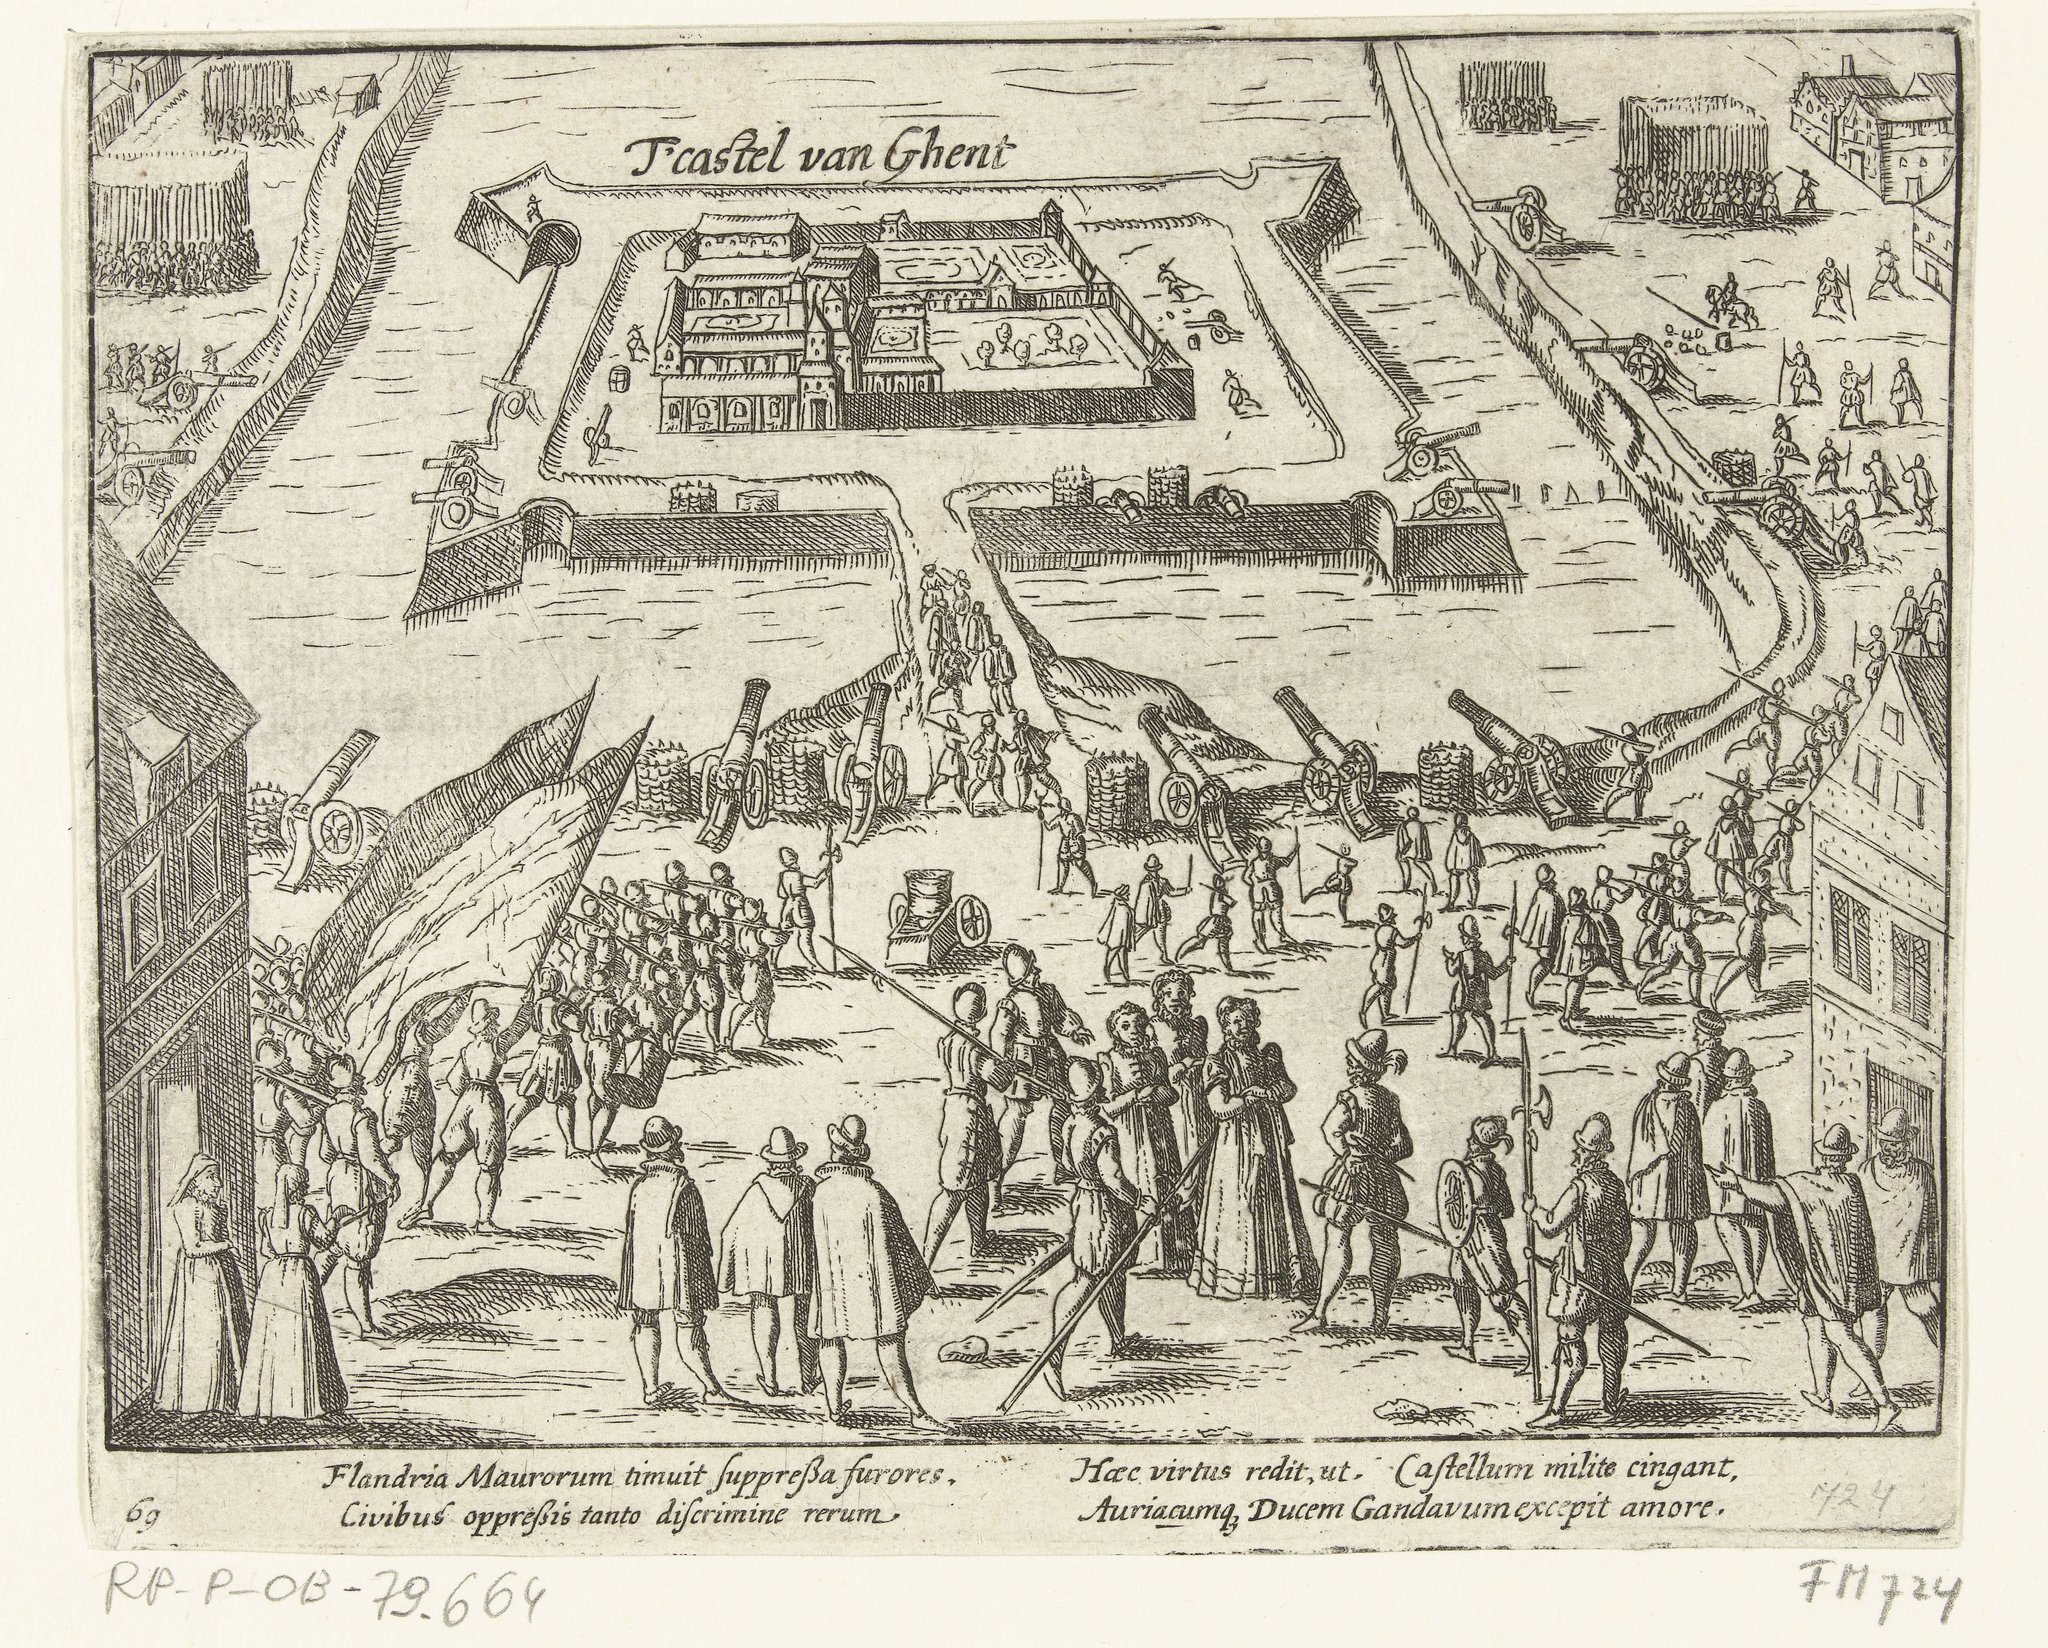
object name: history print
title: Aftocht van de Spanjaarden uit Gent, 1576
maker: Anonymous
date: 1613-1615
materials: paper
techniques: etching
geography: northern netherlands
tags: antwerp, capture of city (after the siege), ghent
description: Aftocht van de Spanjaarden onder vrijgeleide uit de citadel van Gent na beleg door het Staatse leger, 9 november 1576. Op de voorgrond de vrouw van de Spaanse legeraanvoerder Mondragon. Met onderschrift van 4 regels in het Latijn. Genummerd: 69. Bedrukt op achterzijde met tekst in het Latijn.